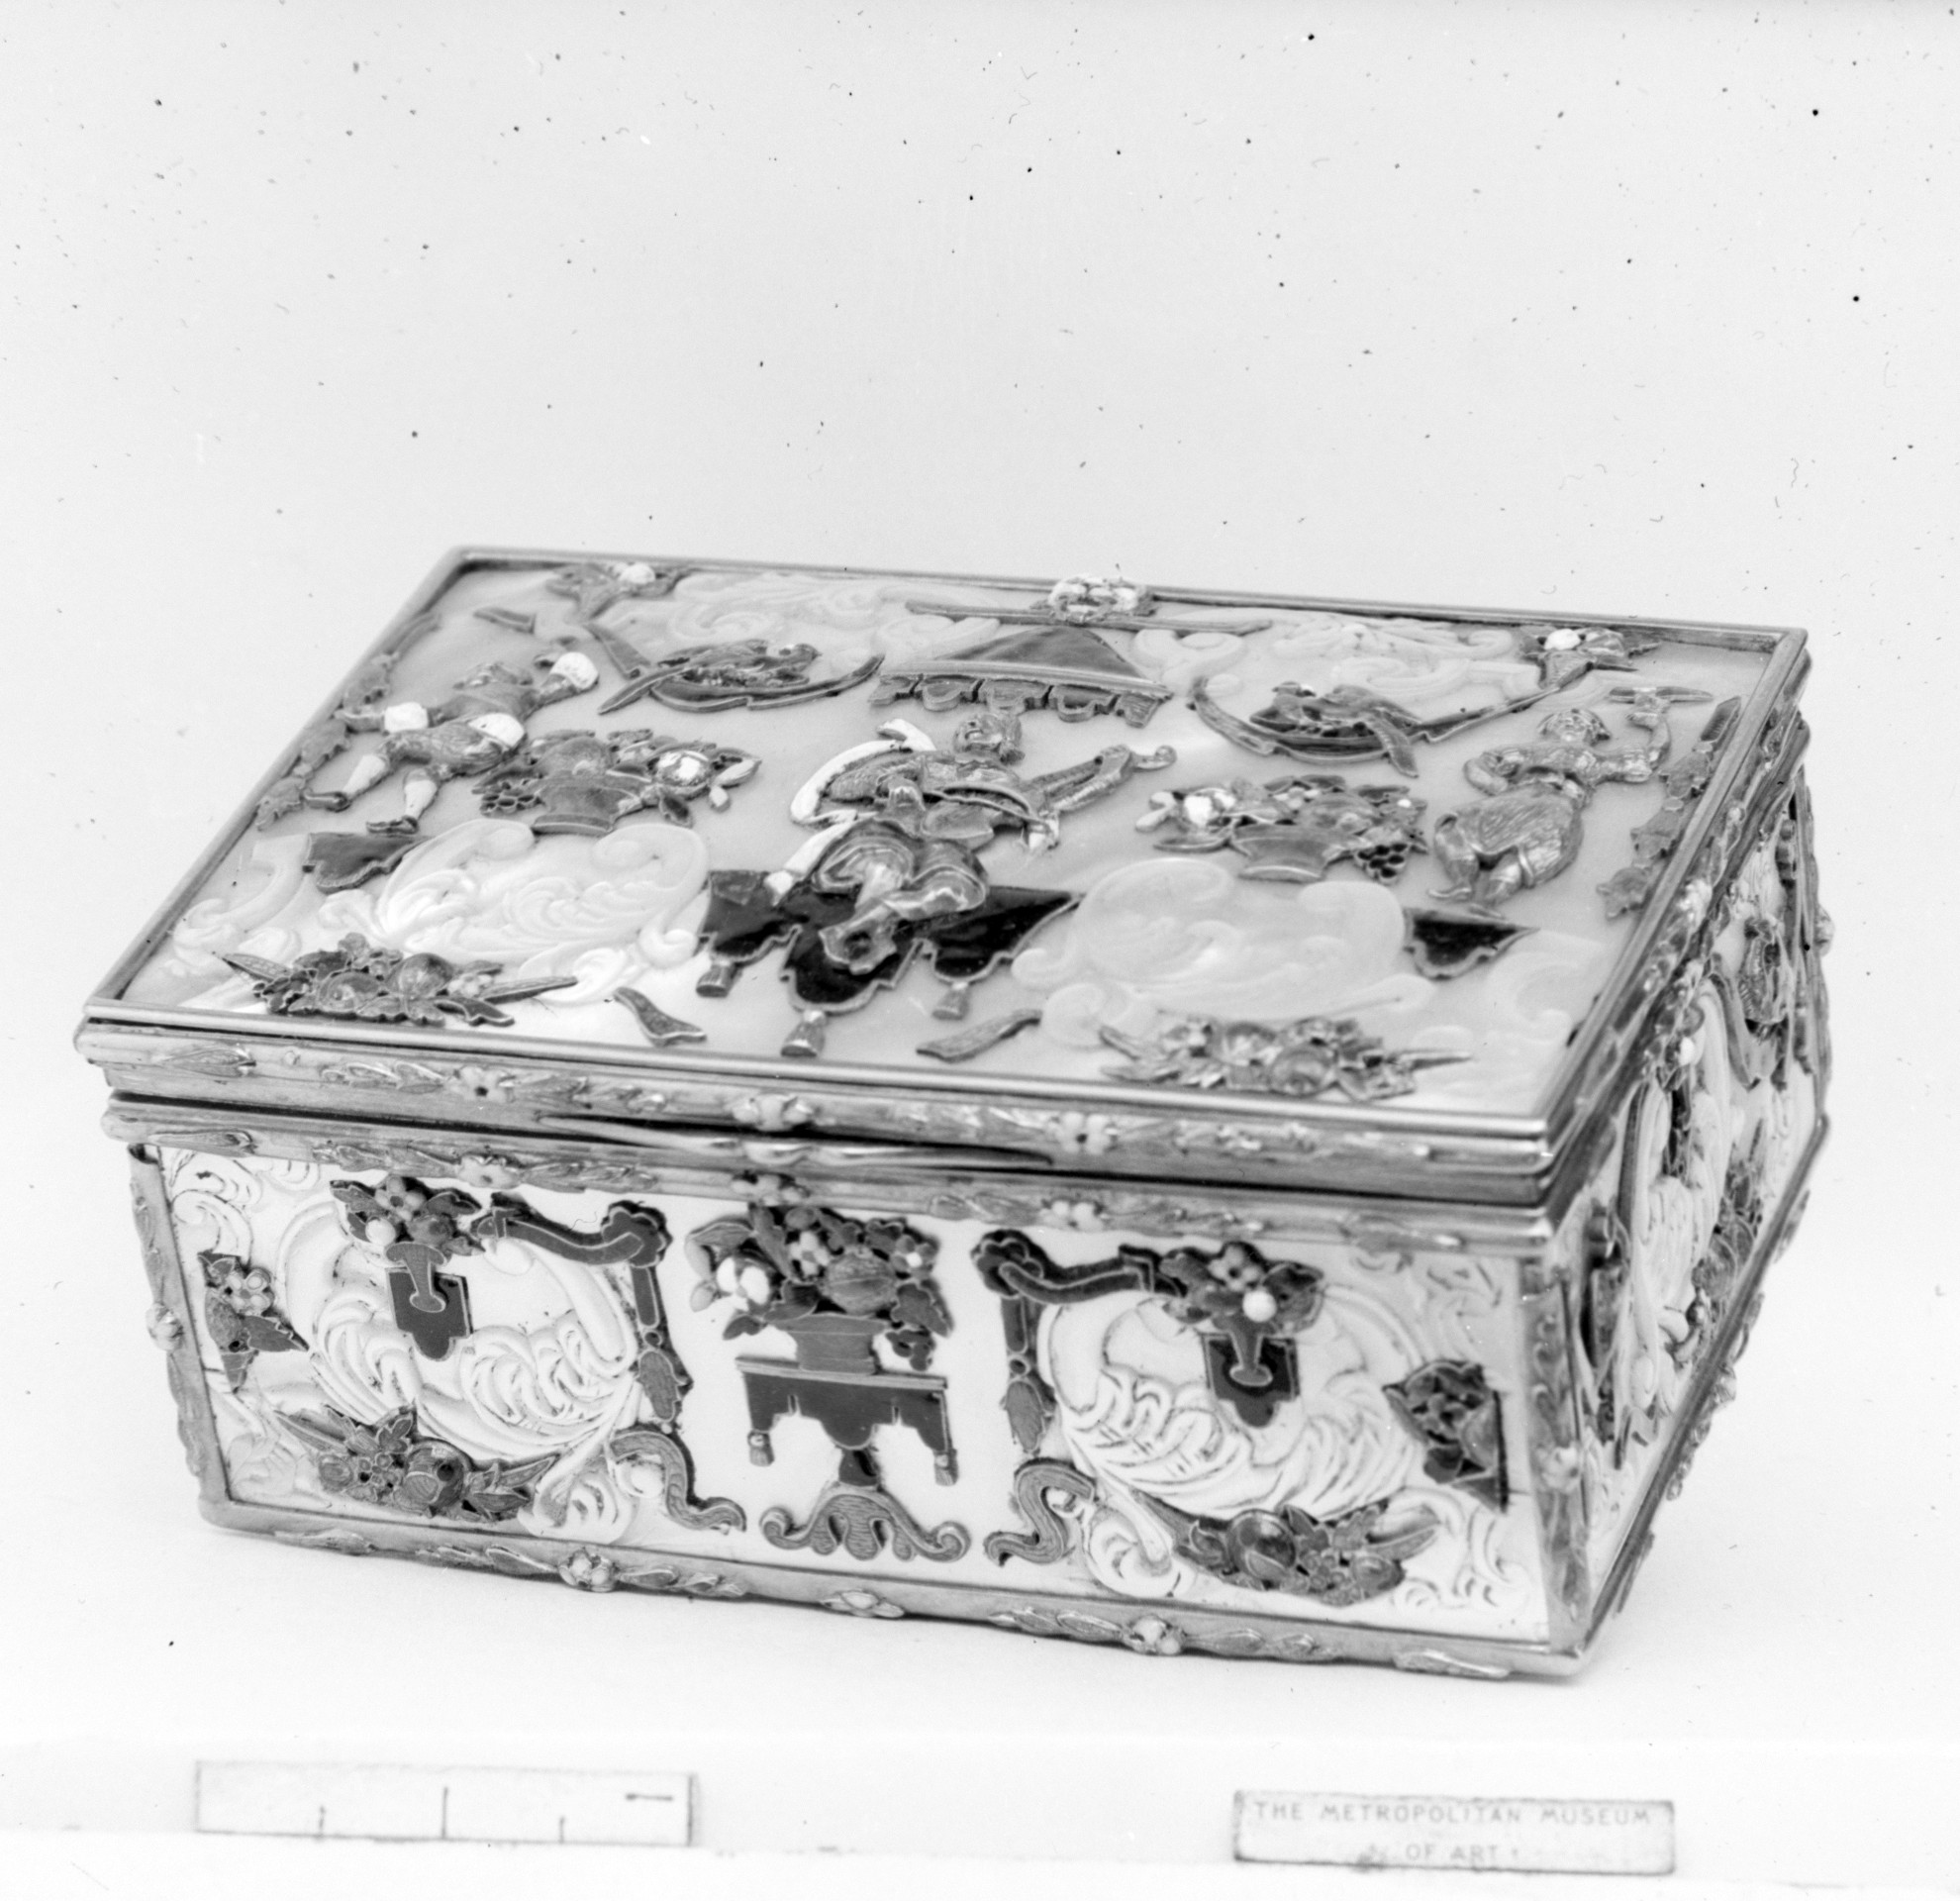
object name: snuffbox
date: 1667-1733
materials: enamel, gold, mother of pearl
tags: men,flowers